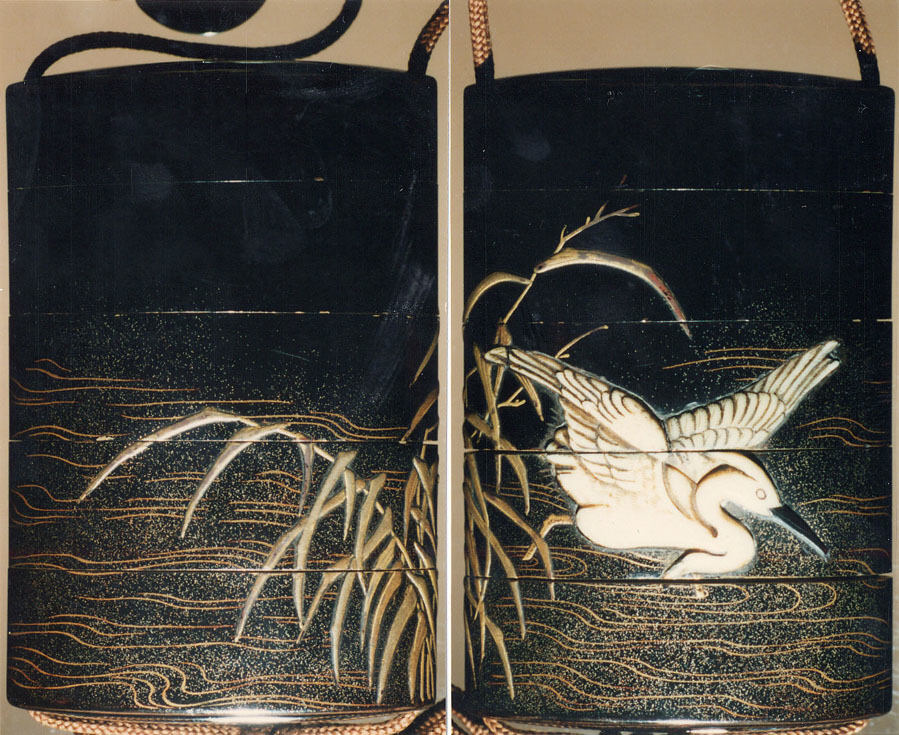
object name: inrō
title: Case (Inrō) with Design of Heron Wading in Shallow Water beside Reeds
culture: japanese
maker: ogawa haritsu (ritsuō)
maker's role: artist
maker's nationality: japanese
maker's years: 1663-1747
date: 1701-1900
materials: gold, horn, ivory, lacquer, silver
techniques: fundame, hiramakie, inlay, roiro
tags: birds,plants